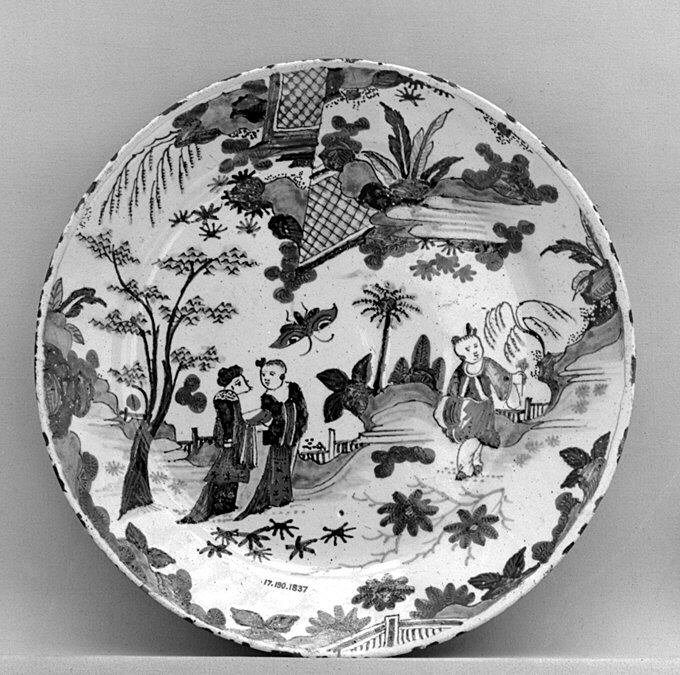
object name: plate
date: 1740-1745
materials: faience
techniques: glazing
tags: human figures,chinoiserie,butterflies,flowers